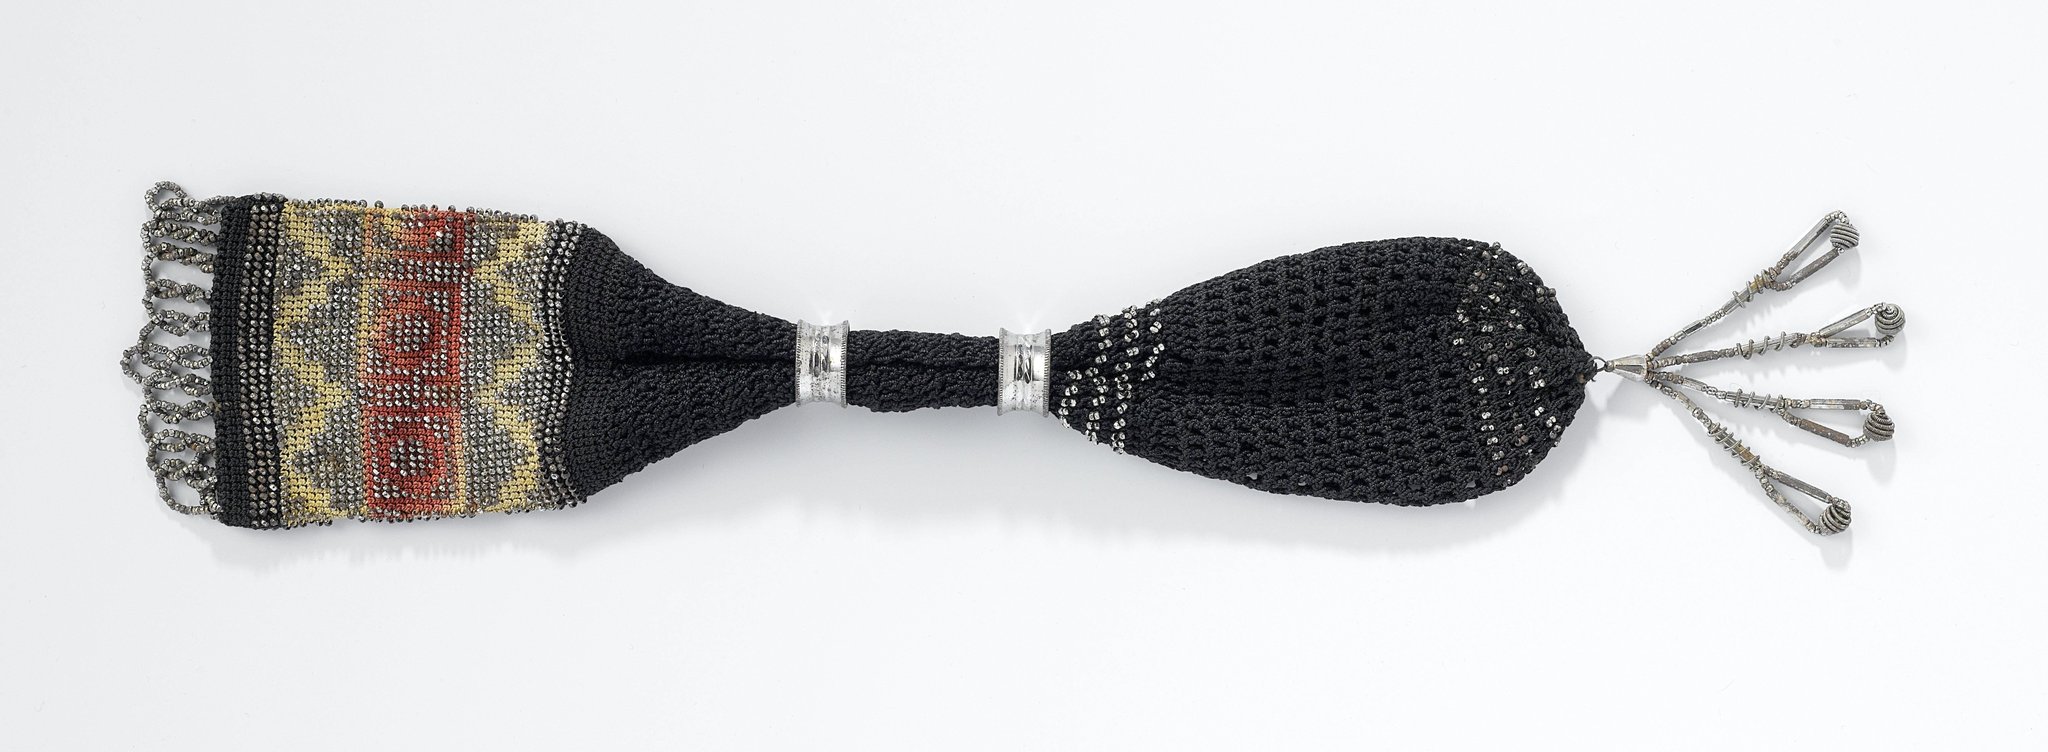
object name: miser's purse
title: Langwerpige sokbeurs van gehaakte zwarte, beige en rode zijde versierd met gepolijste stalen kralen en twee dito ringen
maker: Anonymous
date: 1850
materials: silk, steel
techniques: crochet, forging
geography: netherlands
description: Langwerpige beurs van gehaakte zwarte zijde, met één rechthoekig en één rond uiteinde. Halverwege de beurs is een opening, die met twee zilverkleurige ringen gesloten kan worden. Het ronde gedeelte heeft twee keer drie rijen stalen kralen en een kwast met vier lussen van stalen kralen en spiraalvormige bollen. Het rechthoekige deel bevat een symmetrisch en geometrisch patroon van meegehaakte stalen kralen op een beige en rode ondergrond, met tegen het uiteinde verstrengelde lussen van geregen stalen kralen.